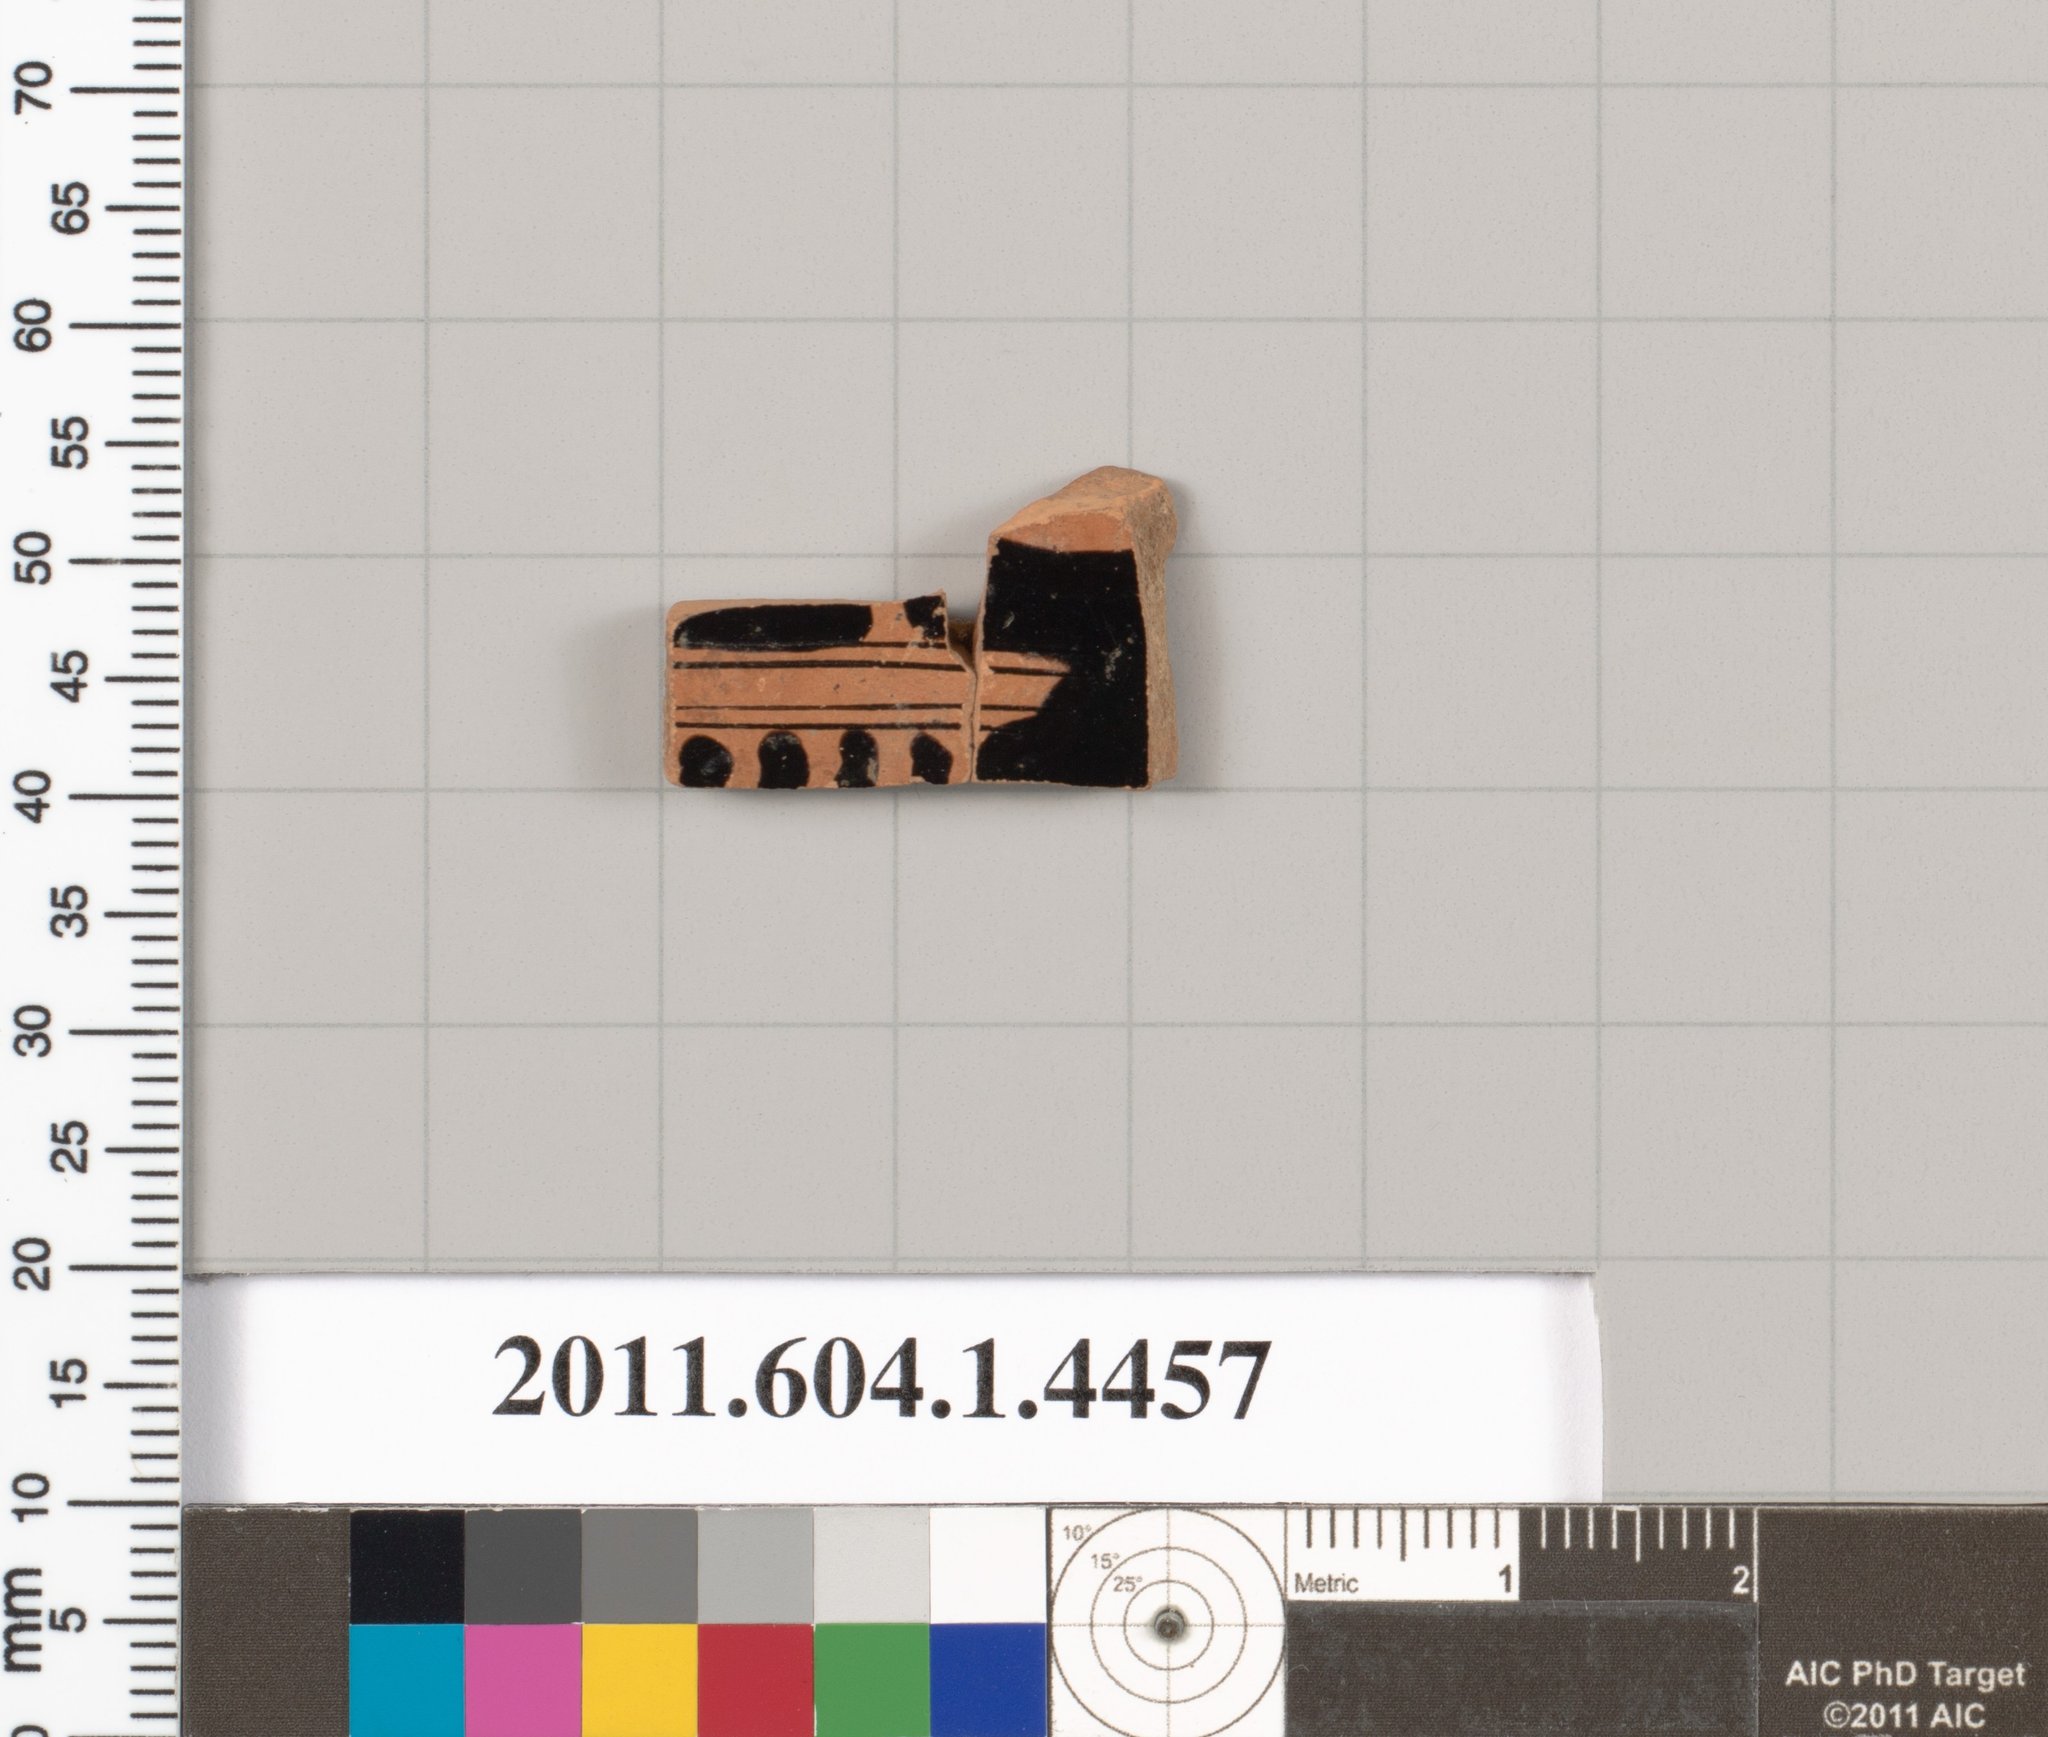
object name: kylix fragment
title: Terracotta fragment of a kylix (drinking cup)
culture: greek, attic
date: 475-451 BCE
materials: terracotta